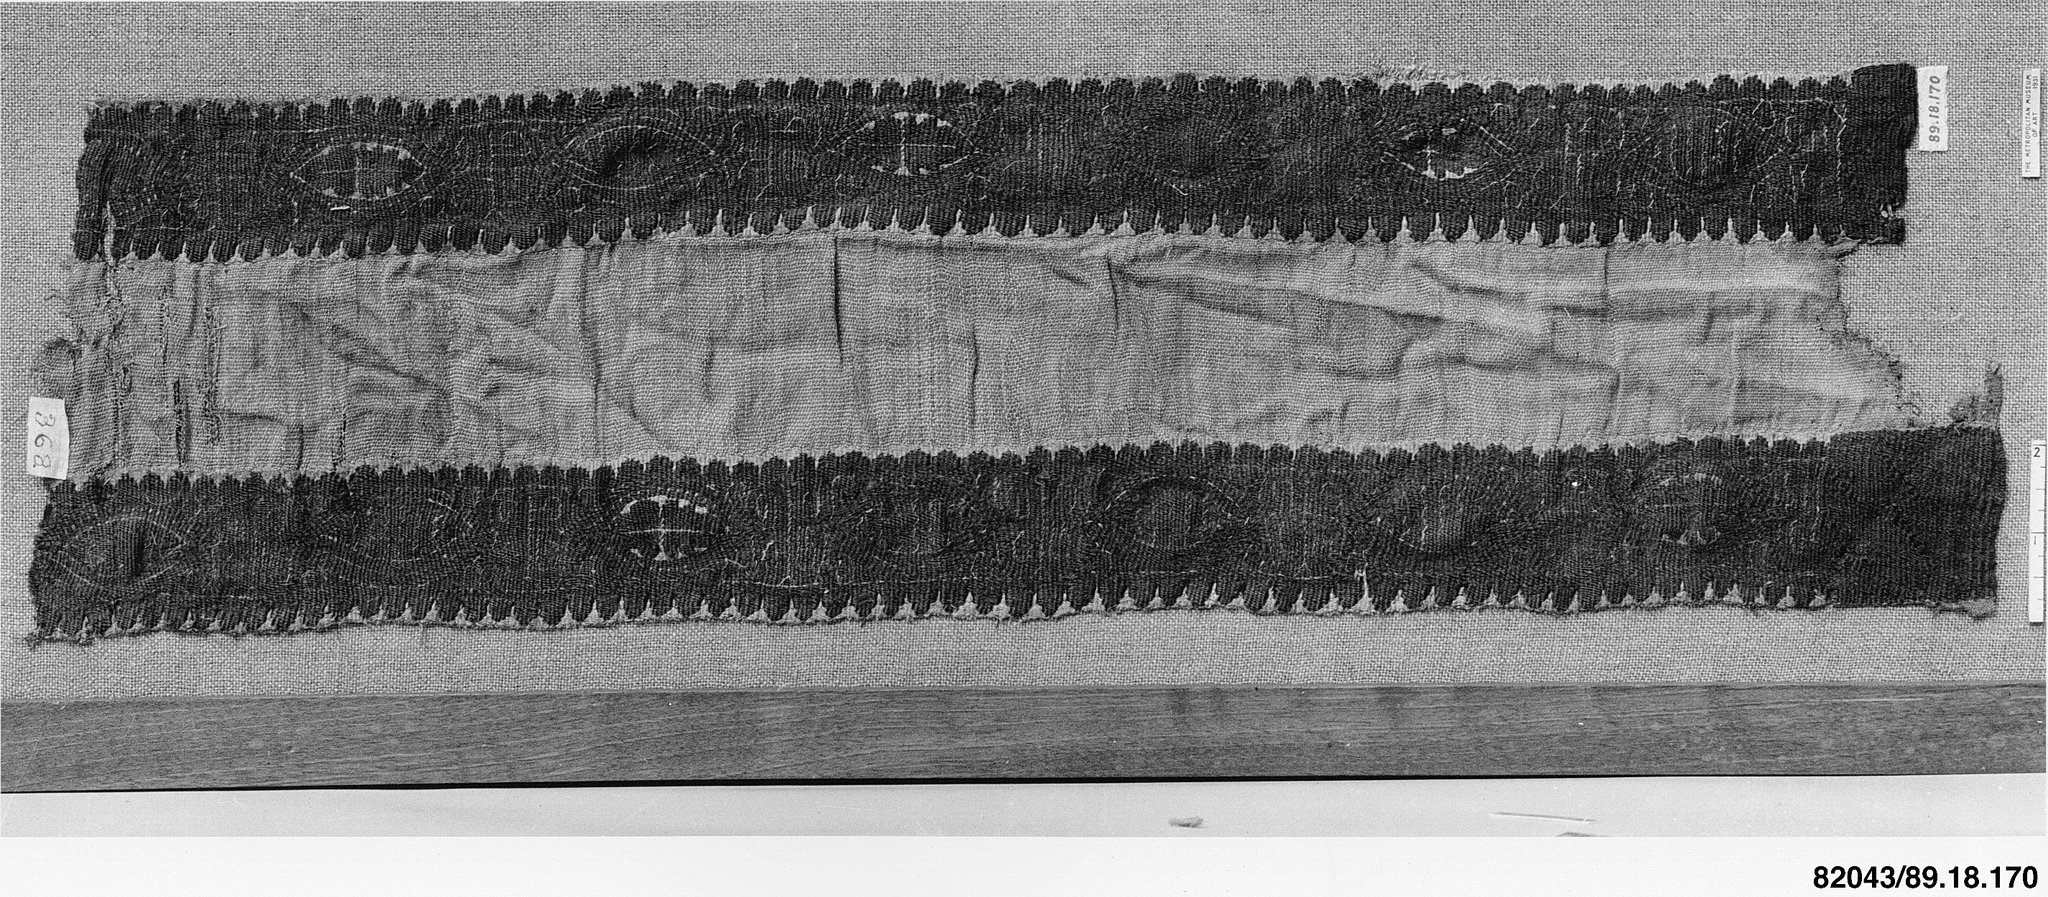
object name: textile fragment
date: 201-400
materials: linen, wool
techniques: weave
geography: egypt